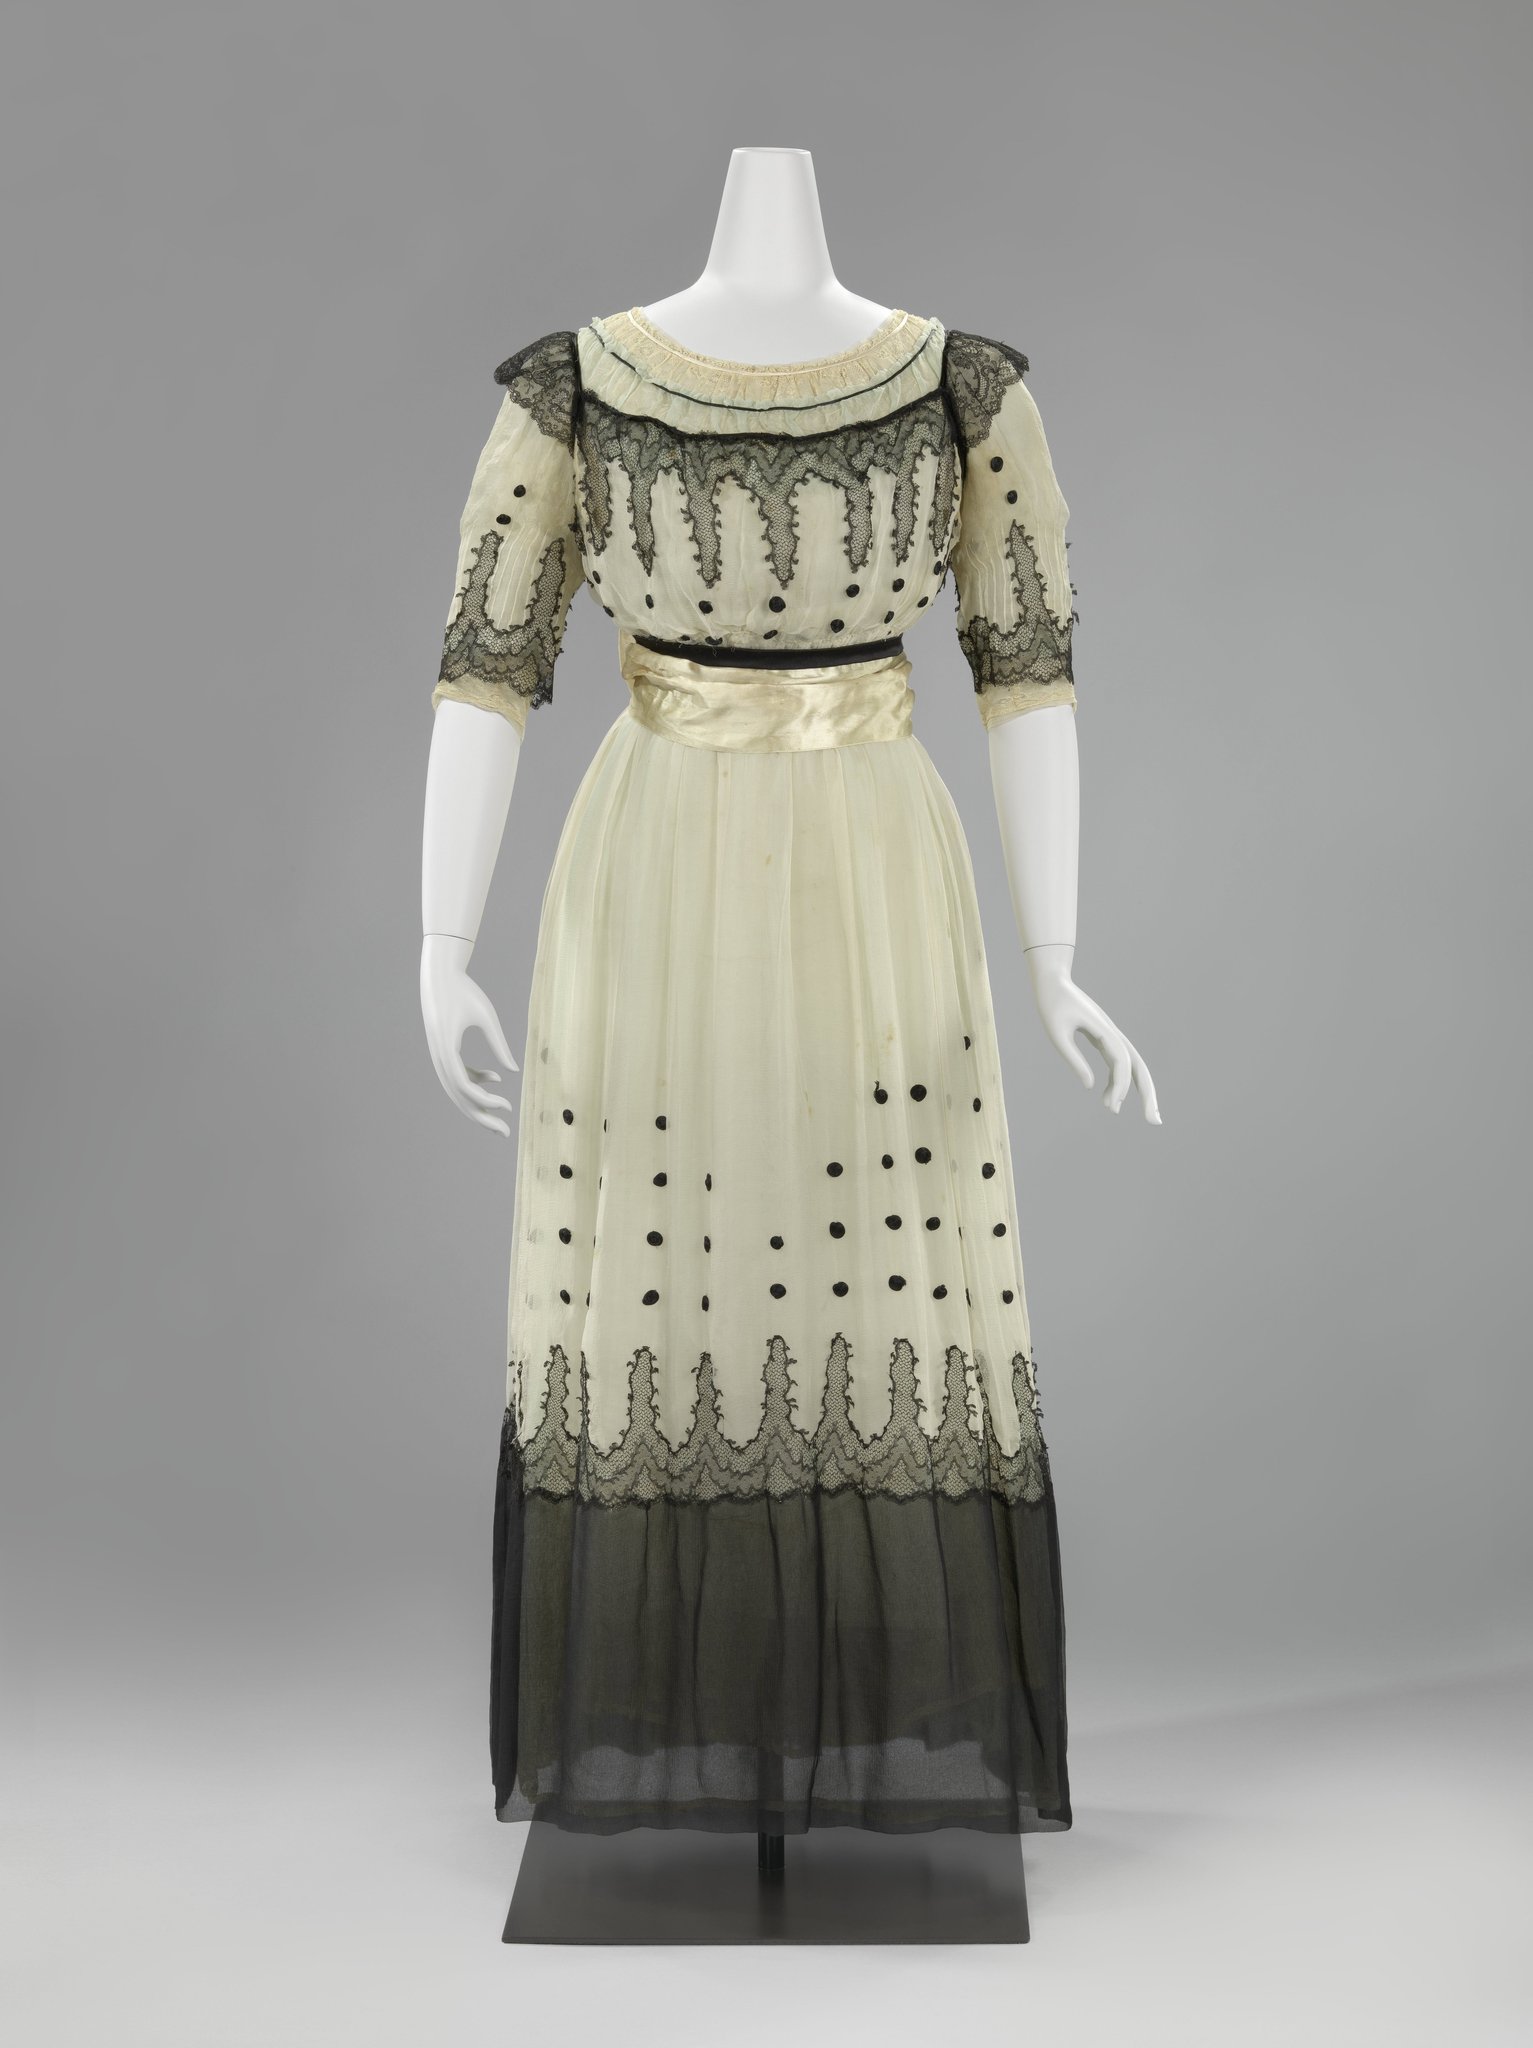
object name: main garment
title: Japon van drie lagen crêpe georgette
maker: Anonymous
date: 1916-1919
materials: silk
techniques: lace, knotting, weave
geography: netherlands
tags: e. kuhn-büchner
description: Japon van drie over elkaar liggende lagen crêpe georgette, langs de hals, op het lijf, aan de manchetten en de rok versierd met machinale Chantilly kant en voorzien van een satijnen knoopceintuur eindigend in geknoopte satijnen koorden. Model: Lage rechte hals, hoge taille en halflange mouwen. De jurk bestaat uit twee lagen: een witte bovenjurk en lichtblauwe onderjurk, die slechts zichtbaar is in de halslijn. De bovenjurk heeft een zeer brede zwarte zoom, waarboven een naar boven uitstulpend kanten entre-deux. Ook aan de hals en onder aan de mouw een zelfde kantaanzet. De mouwen zijn getailleerd door middel van meerdere verticale sieraden. Voering van witte crèpe. Versiering: in de hals en mouwen en op de schouders machinaal Chantilly kant. Op de mouwen, het lijfje en boven het kanten entre-deux in de rok rijen zwarte satijnen knoopjes. In de taille een brede zwart/witte satijnen ceintuur, die op de rug gestrikt wordt en eindigt in tweekleurige bollen, waaraan geknoopte satijnen koorden.